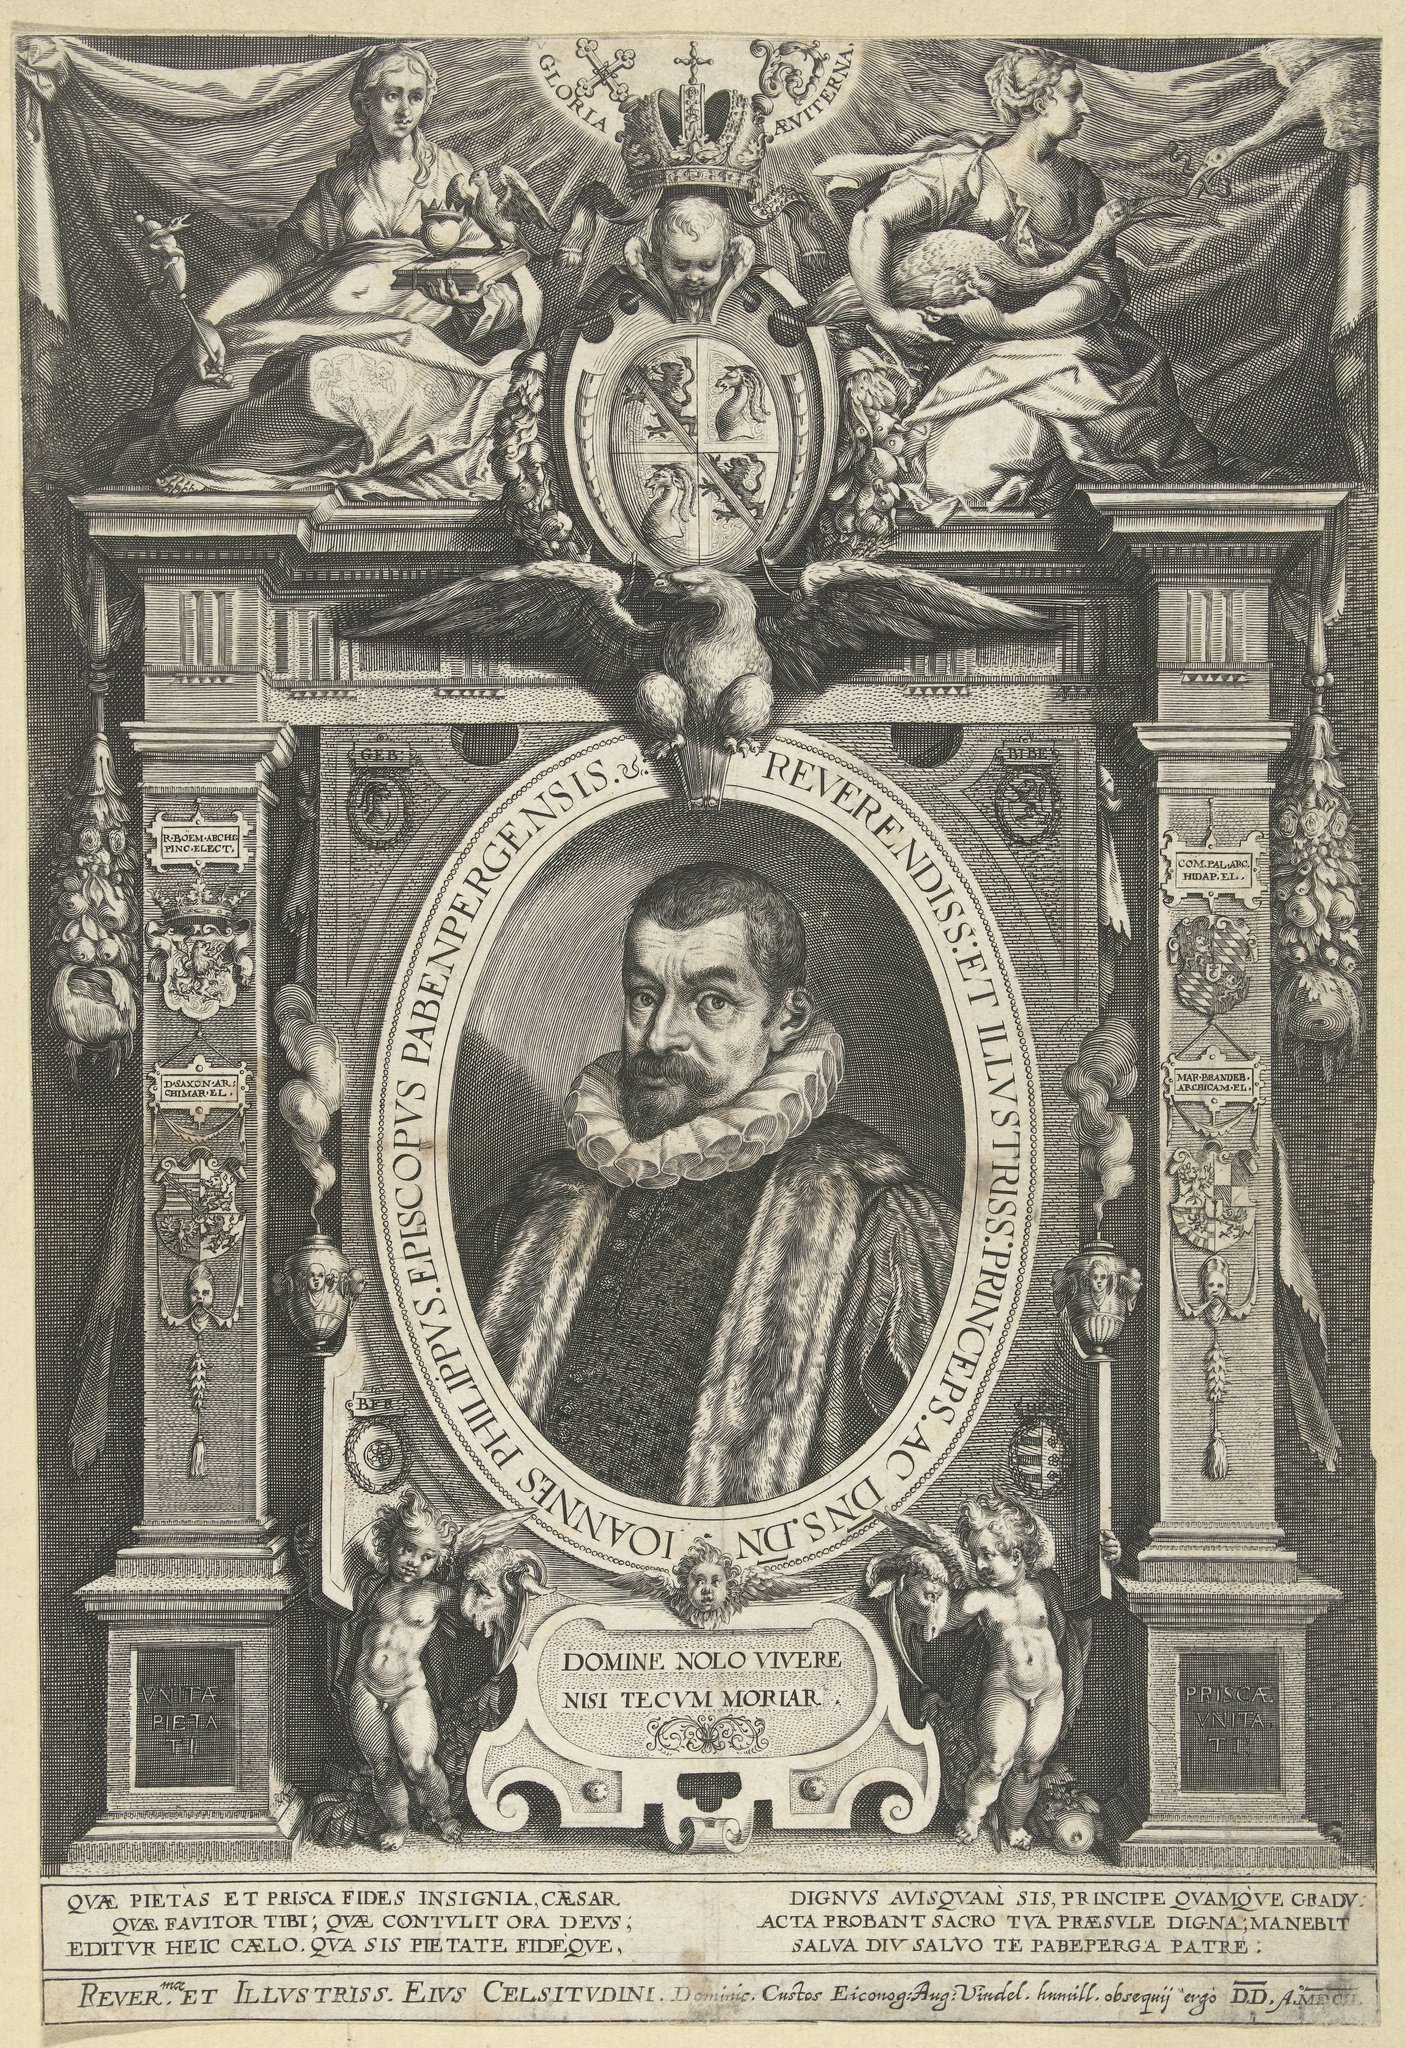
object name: print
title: Portret van Johan Philips van Gebsattel, vorstbisschop van Bamberg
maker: dominicus custos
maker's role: print maker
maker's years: 1560-1615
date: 1602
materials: paper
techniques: engraving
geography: augsburg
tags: prudence, 'prudentia'; 'prudenza' (ripa) ~ one of the four cardinal virtues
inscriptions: collector's mark: Lugt 2228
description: Portret van Johan Philips van Gebsattel, vorstbisschop van Bamberg, in ovaal met randschrift. Boven het portret het bisschoppelijke wapen van Gebsattel. Naast het wapen Voorzichtigheid en een vrouw met een vogel in haar armen die gevoerd wordt door een tweede vogel.